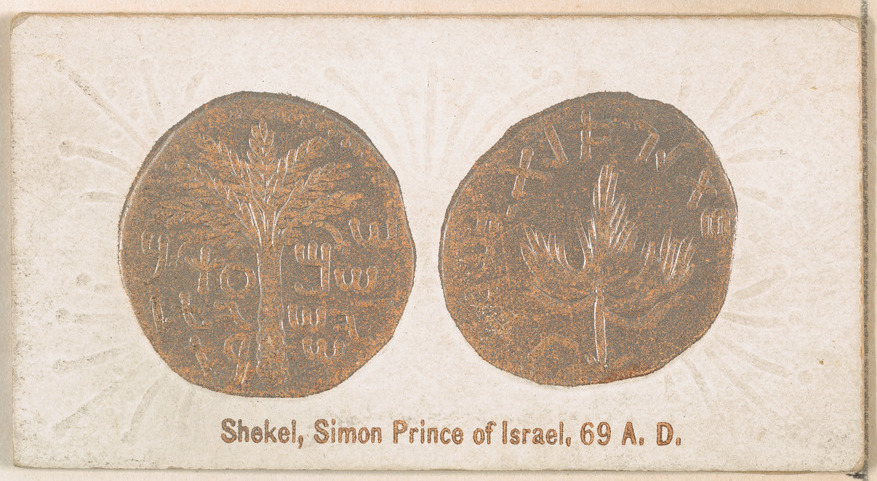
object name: print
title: Shekel, Simon Prince of Israel, 69 A.D., from the Ancient Coins series (N180) issued by Wm. S. Kimball & Co.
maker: william s. kimball & company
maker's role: publisher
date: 1888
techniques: color lithograph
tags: coins